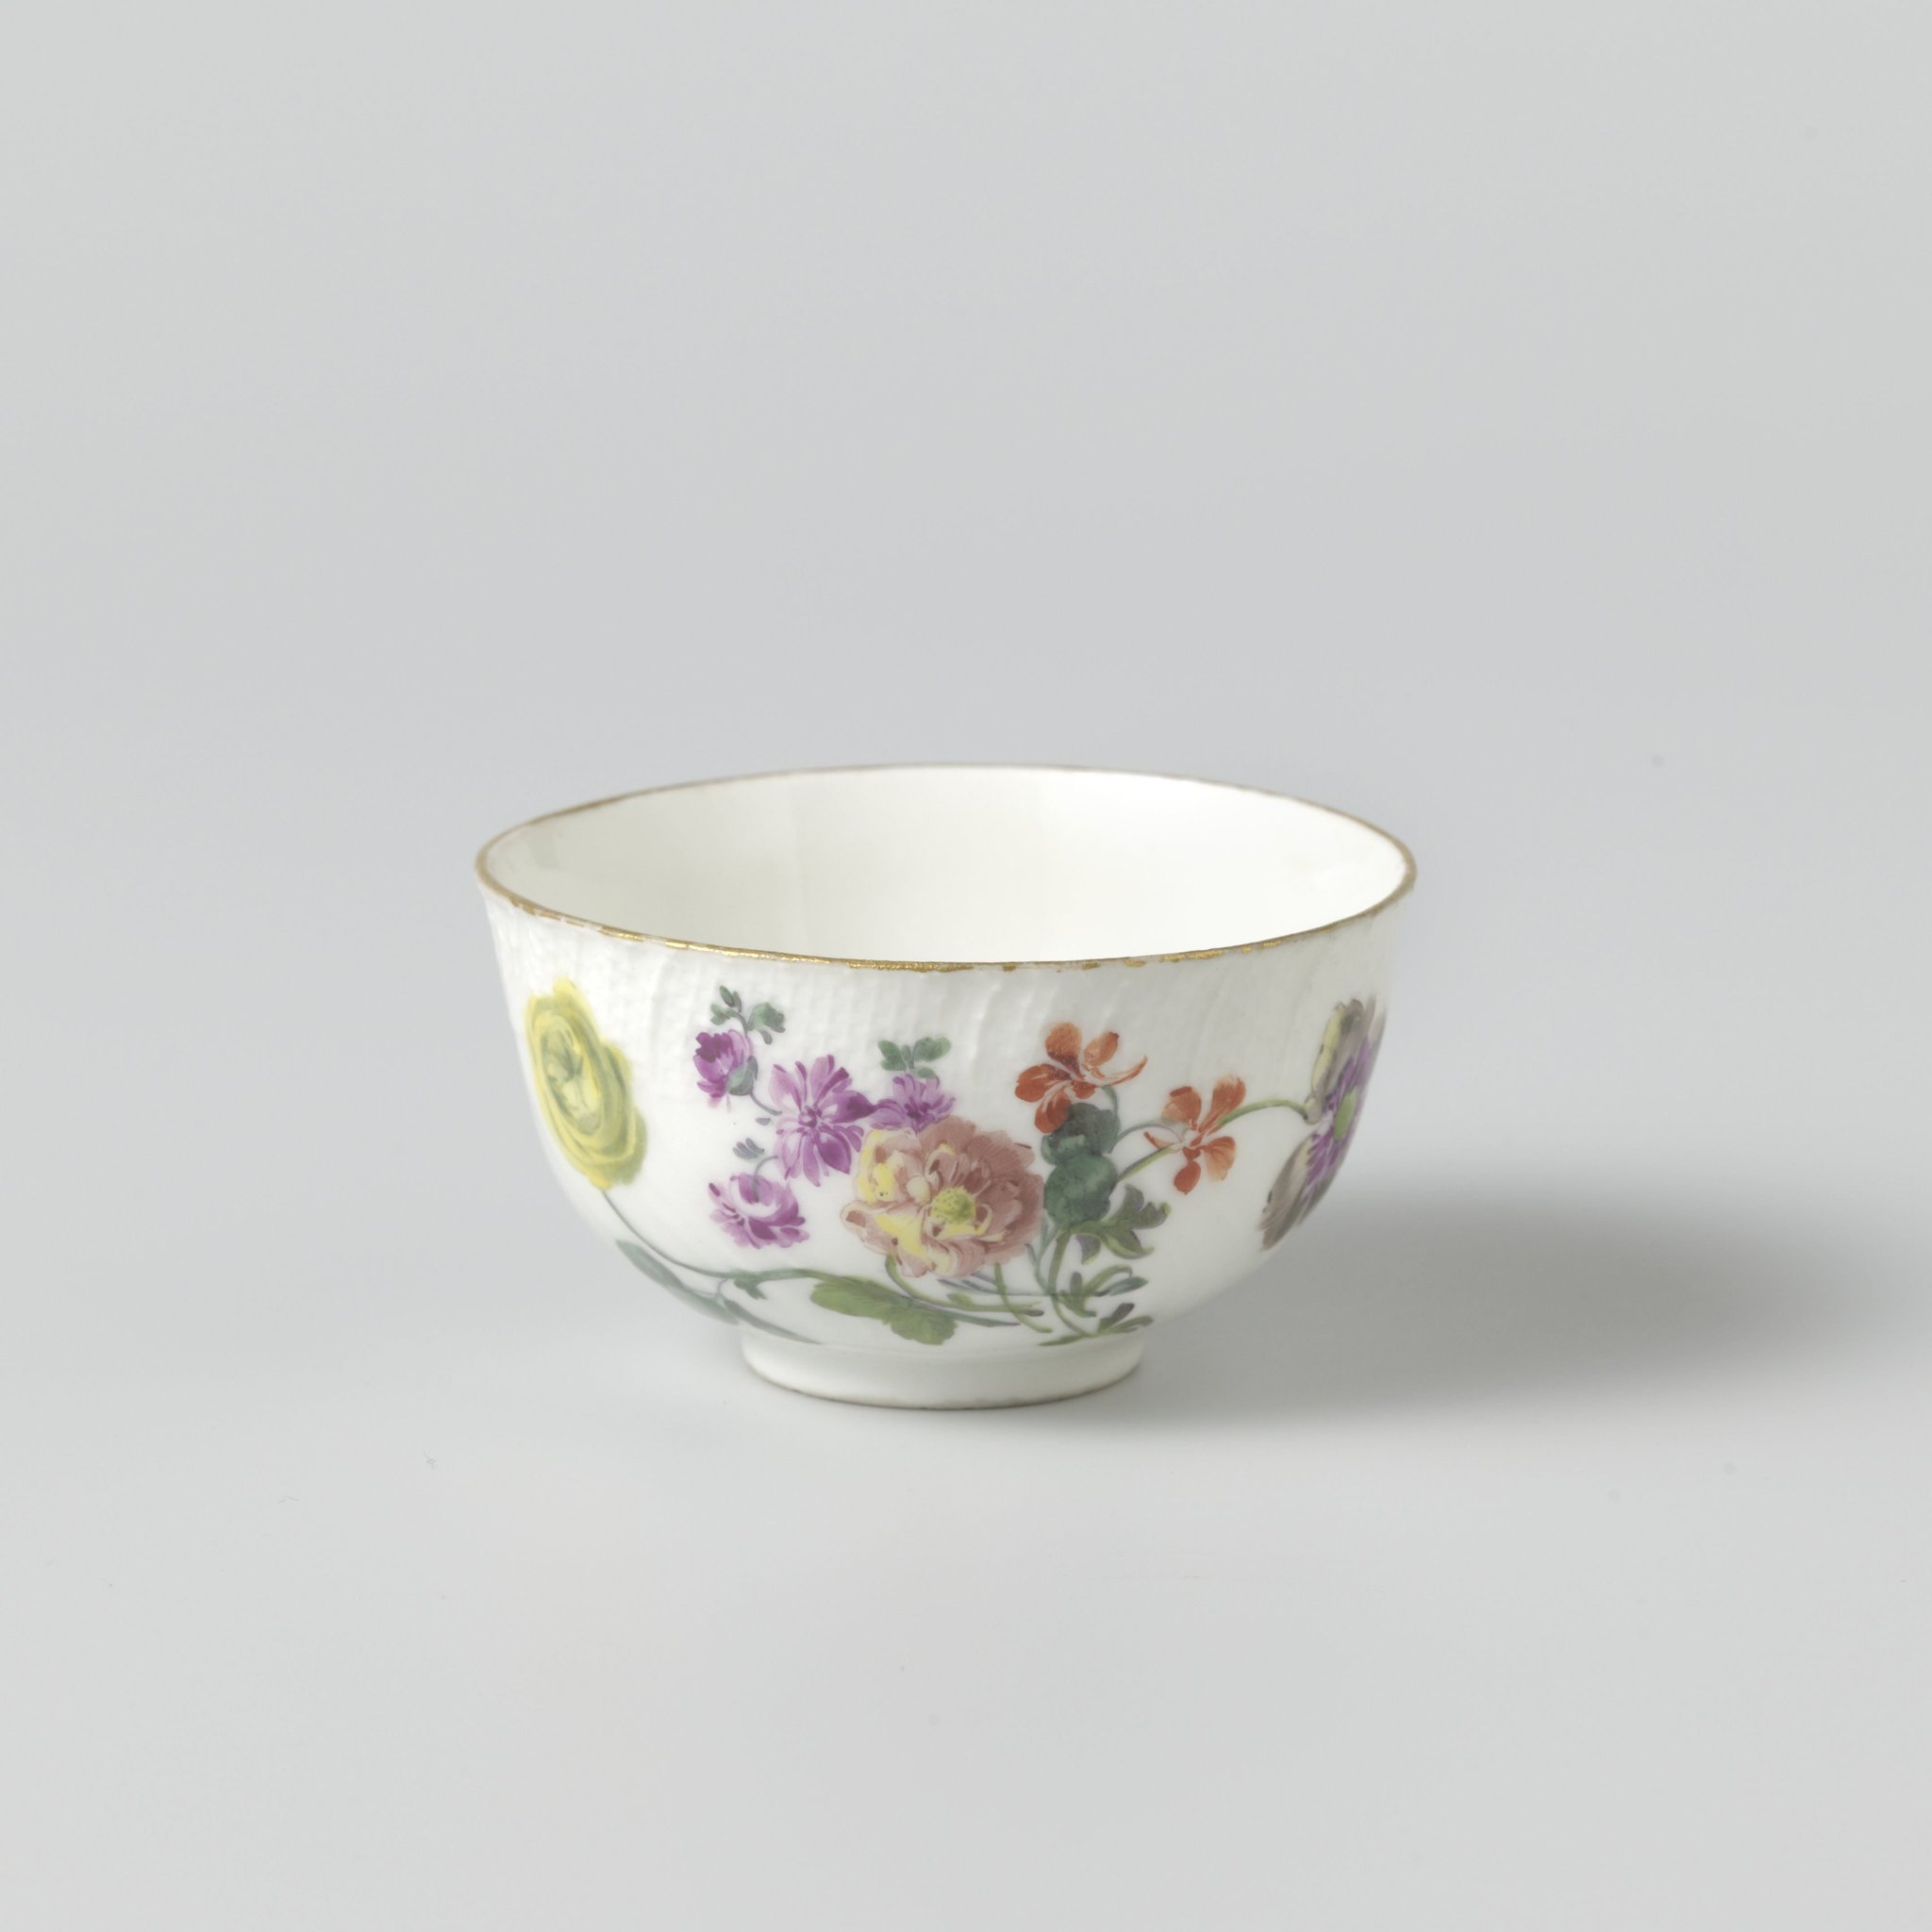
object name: cup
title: Kop, veelkleurig beschilderd met bloemboeketten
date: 1750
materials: porcelain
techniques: painted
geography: meissen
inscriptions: mold mark: ‘63’, factory mark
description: Halfbolvormige kop van beschilderd porselein. De kop is beschilderd met bloemboeketten. De rand is versierd met het Neuozier-patroon. De kop is gemerkt.